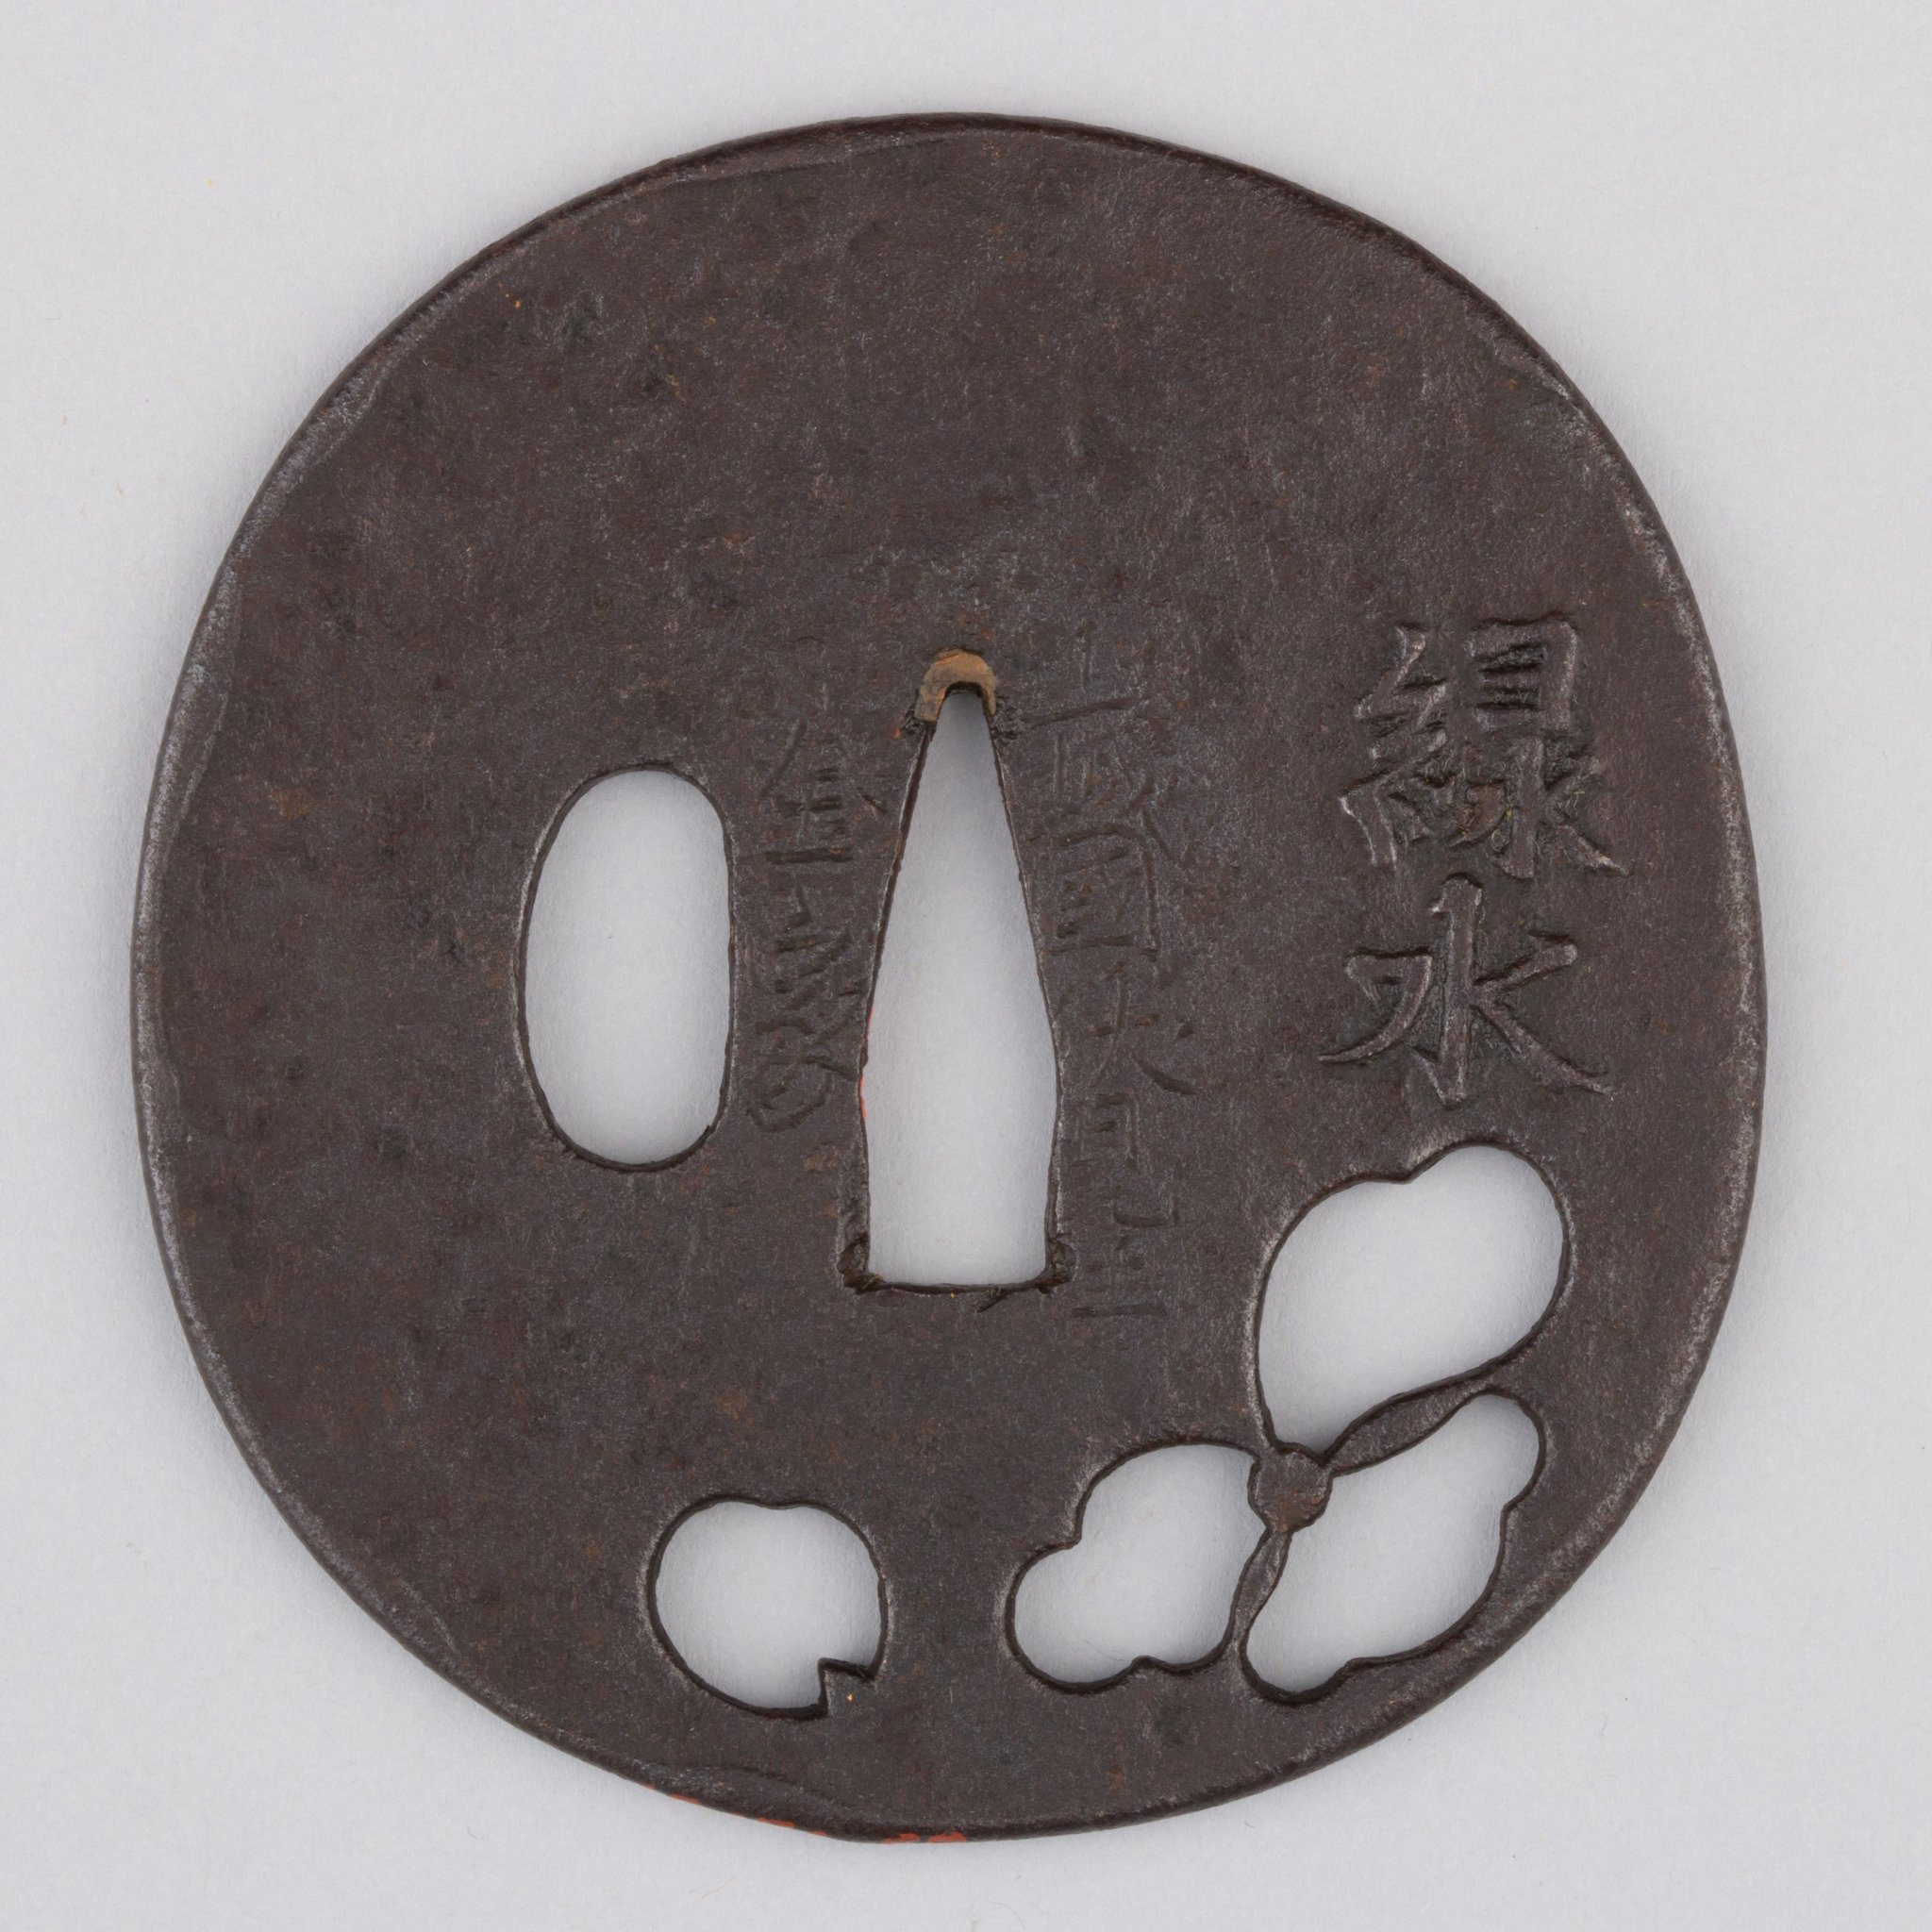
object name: sword guard tsuba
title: Sword Guard (Tsuba)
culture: japanese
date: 1615-1868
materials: copper, iron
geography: japan